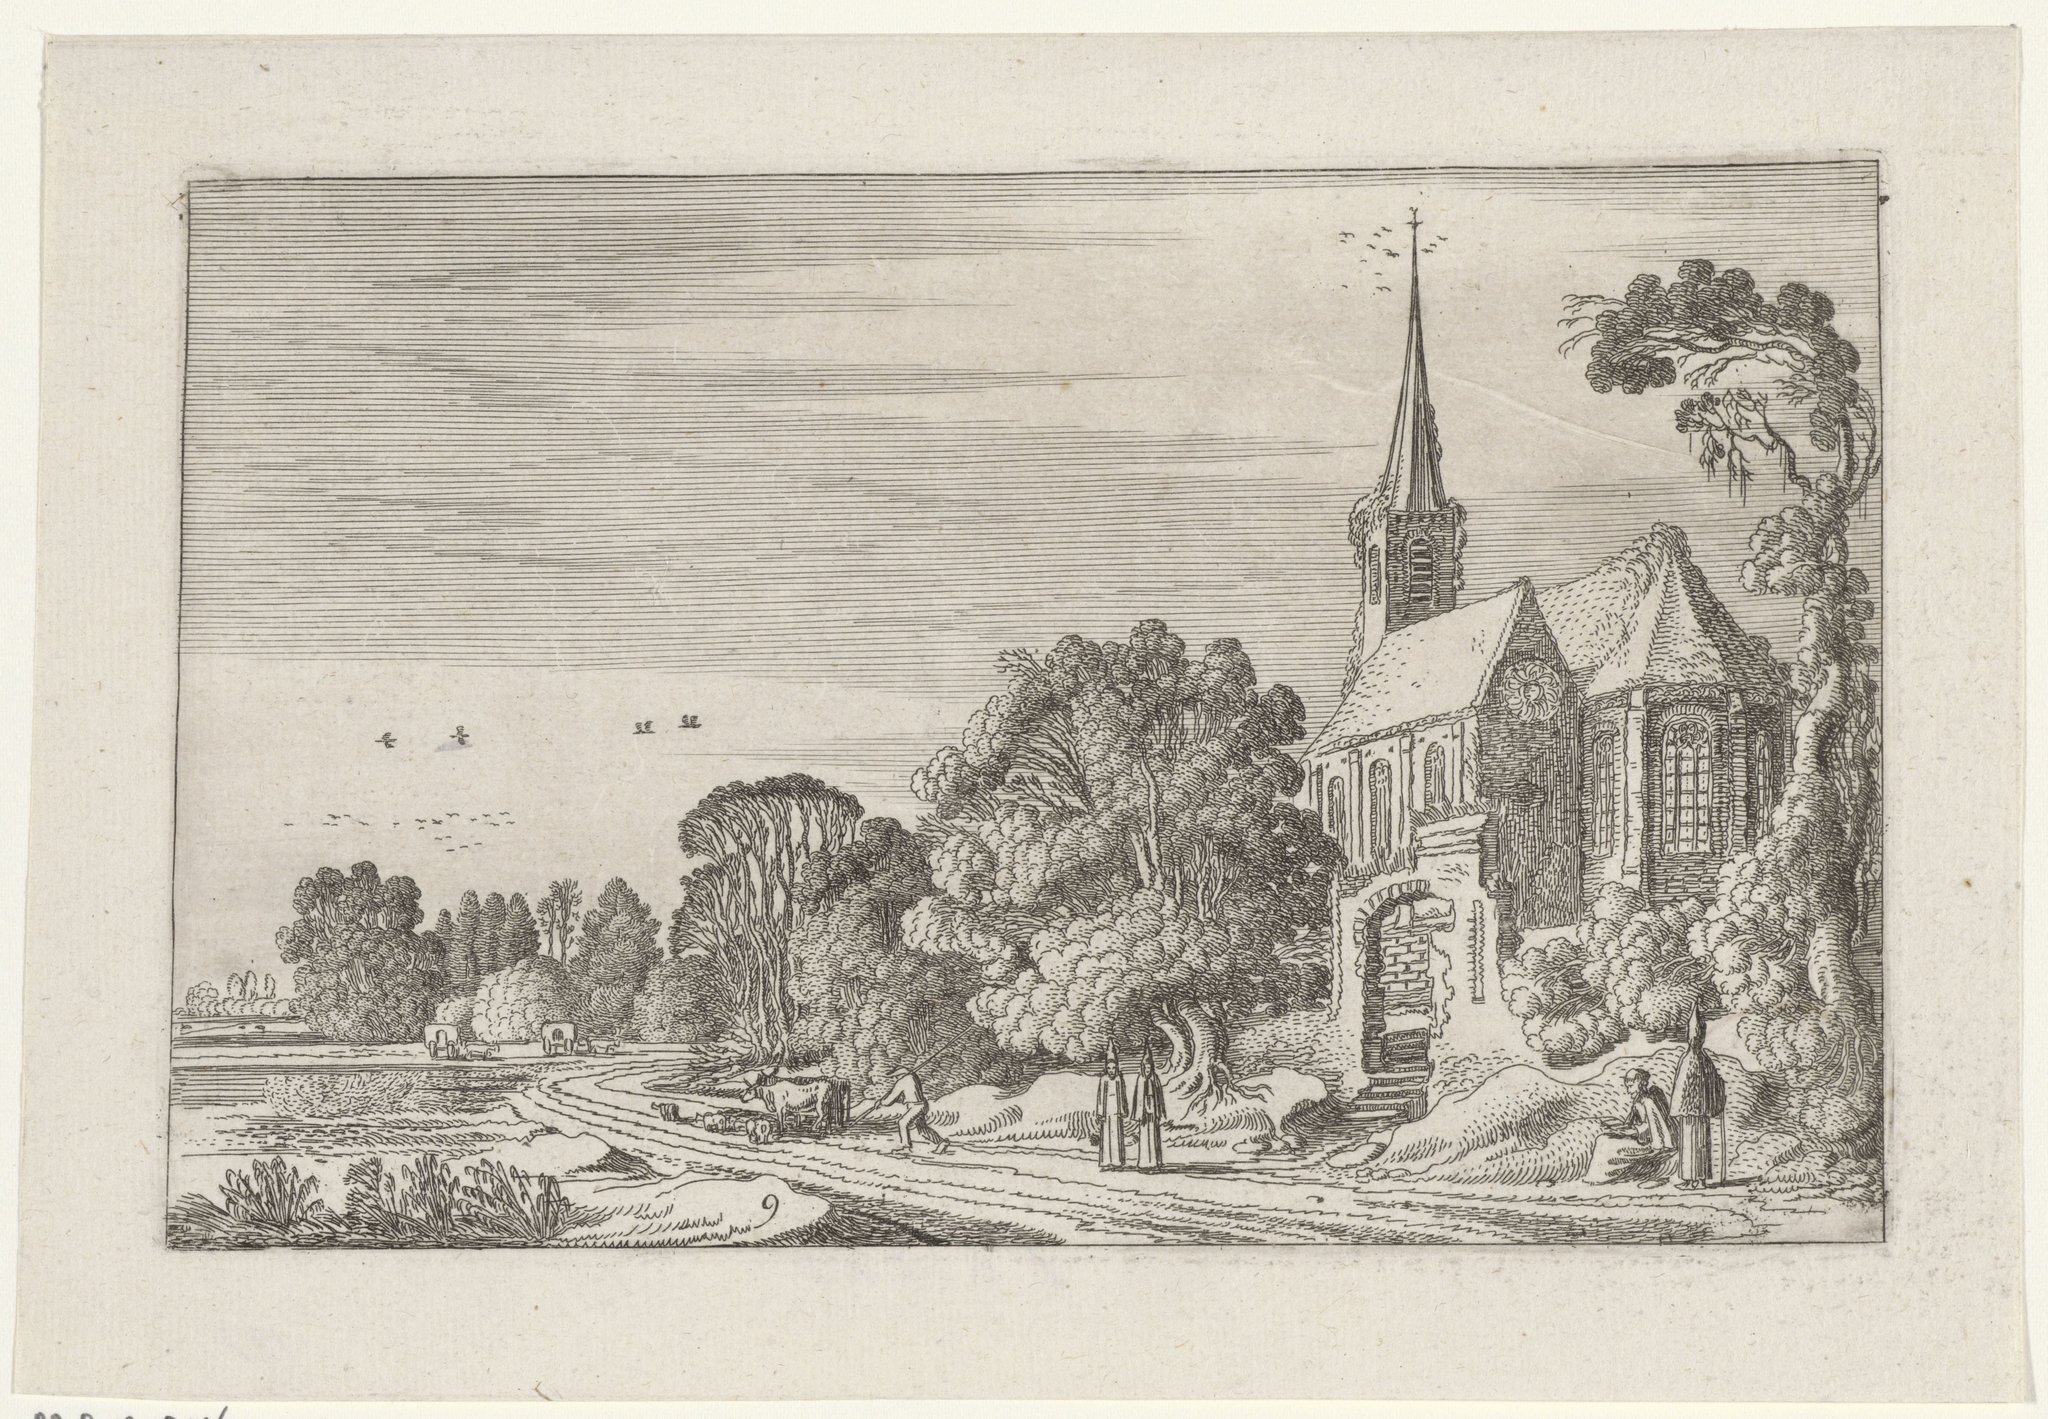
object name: print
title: Vetustae Ruinae et Venustissimae aliquot Regiones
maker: jan van de velde (ii)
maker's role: draughtsman, painter, print maker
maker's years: 1593-1641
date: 1616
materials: paper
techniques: etching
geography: northern netherlands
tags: herding, herdsman, herdswoman, shepherd, shepherdess, cowherd, etc., church (exterior), landscape with ruins, monk(s), friar(s), ruin of church, monastery, etc.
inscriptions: collector's mark: Lugt 240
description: Kloosterlingen en een herder op een landweg langs een vervallen kerk. Negende prent van een serie van zestien.